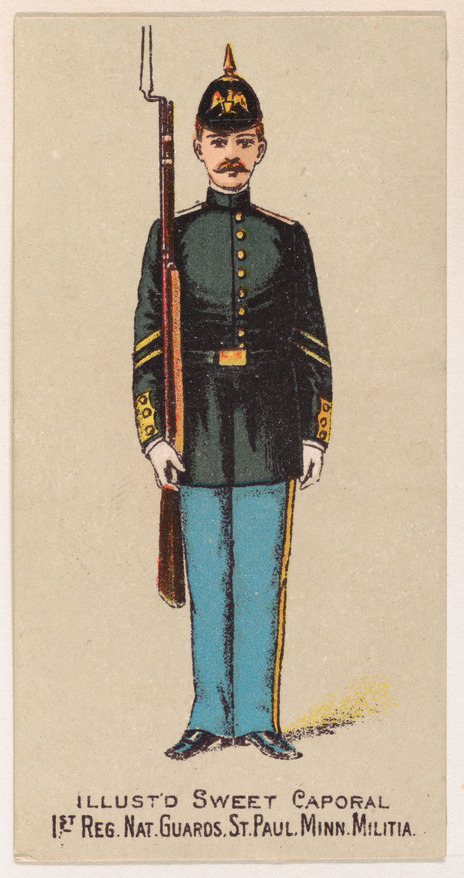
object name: print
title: 1st Regiment, National Guards, St. Paul, Minnesota Militia, from the Military Series (N224) issued by Kinney Tobacco Company to promote Sweet Caporal Cigarettes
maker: kinney brothers tobacco company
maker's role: publisher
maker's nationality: american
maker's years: 1869-2011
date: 1888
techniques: color lithograph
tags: military,firearms,men